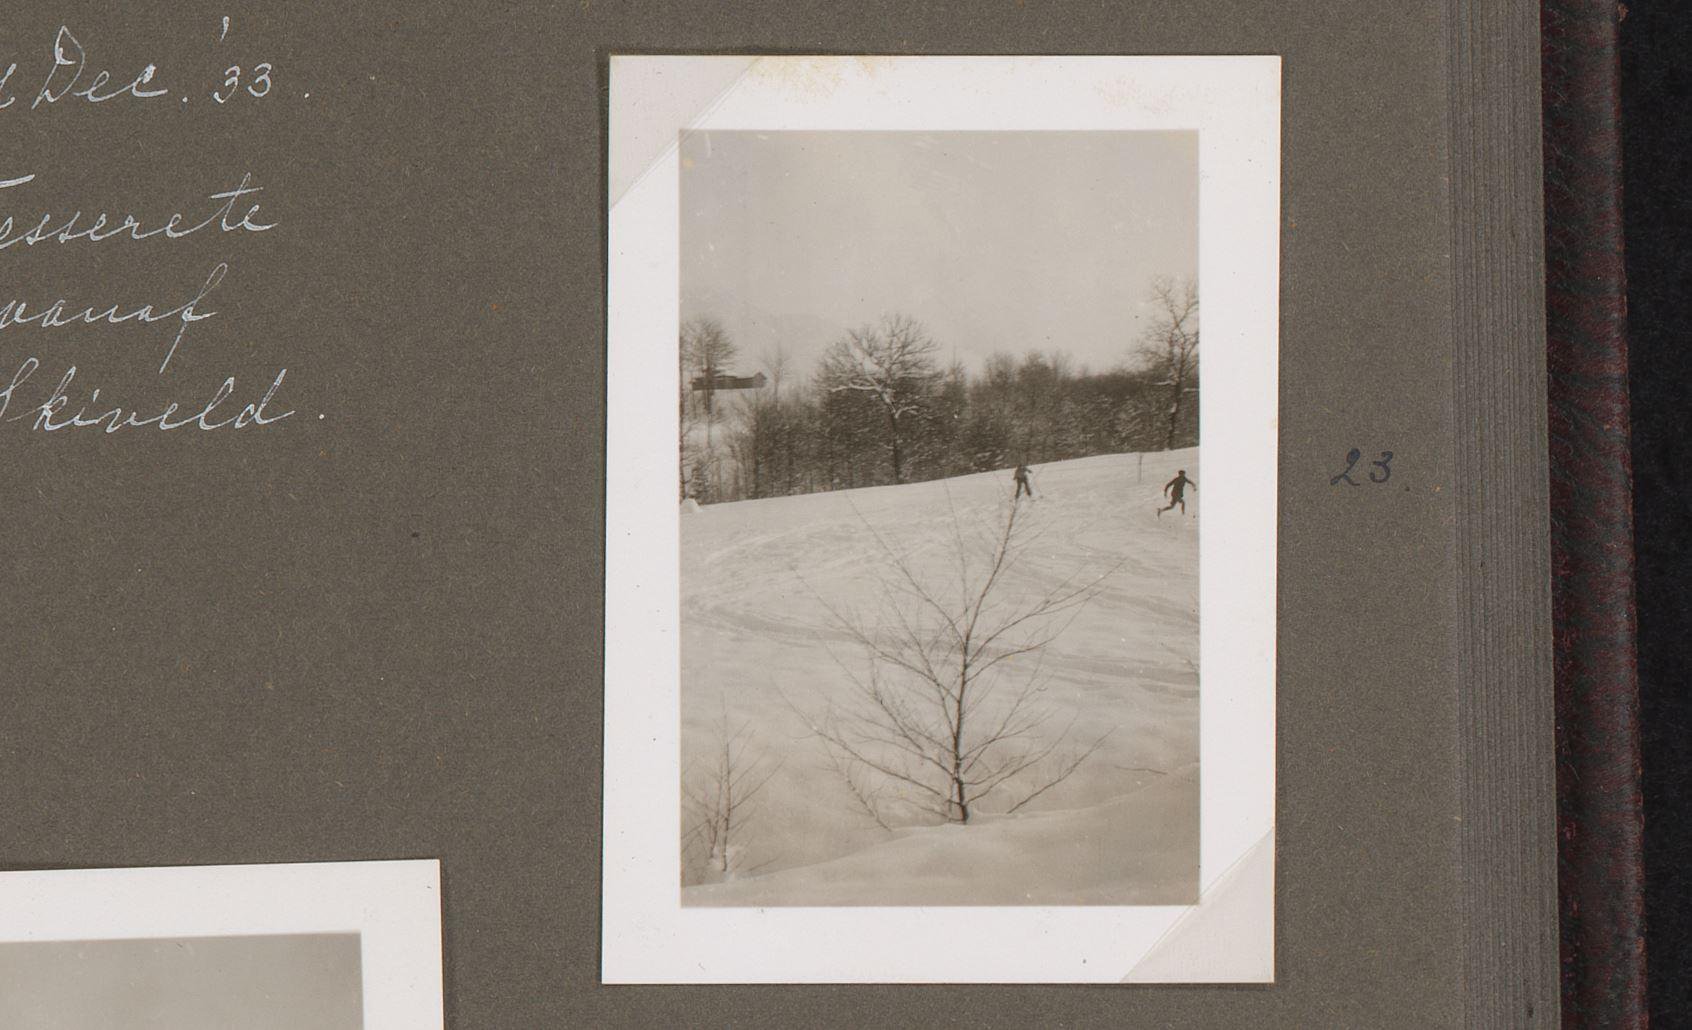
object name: album leaf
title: Twee skiërs in Zwitserland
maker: Anonymous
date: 1933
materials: photographic support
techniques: gelatin silver print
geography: capriasca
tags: skis (winter sports)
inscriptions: number: ‘23’